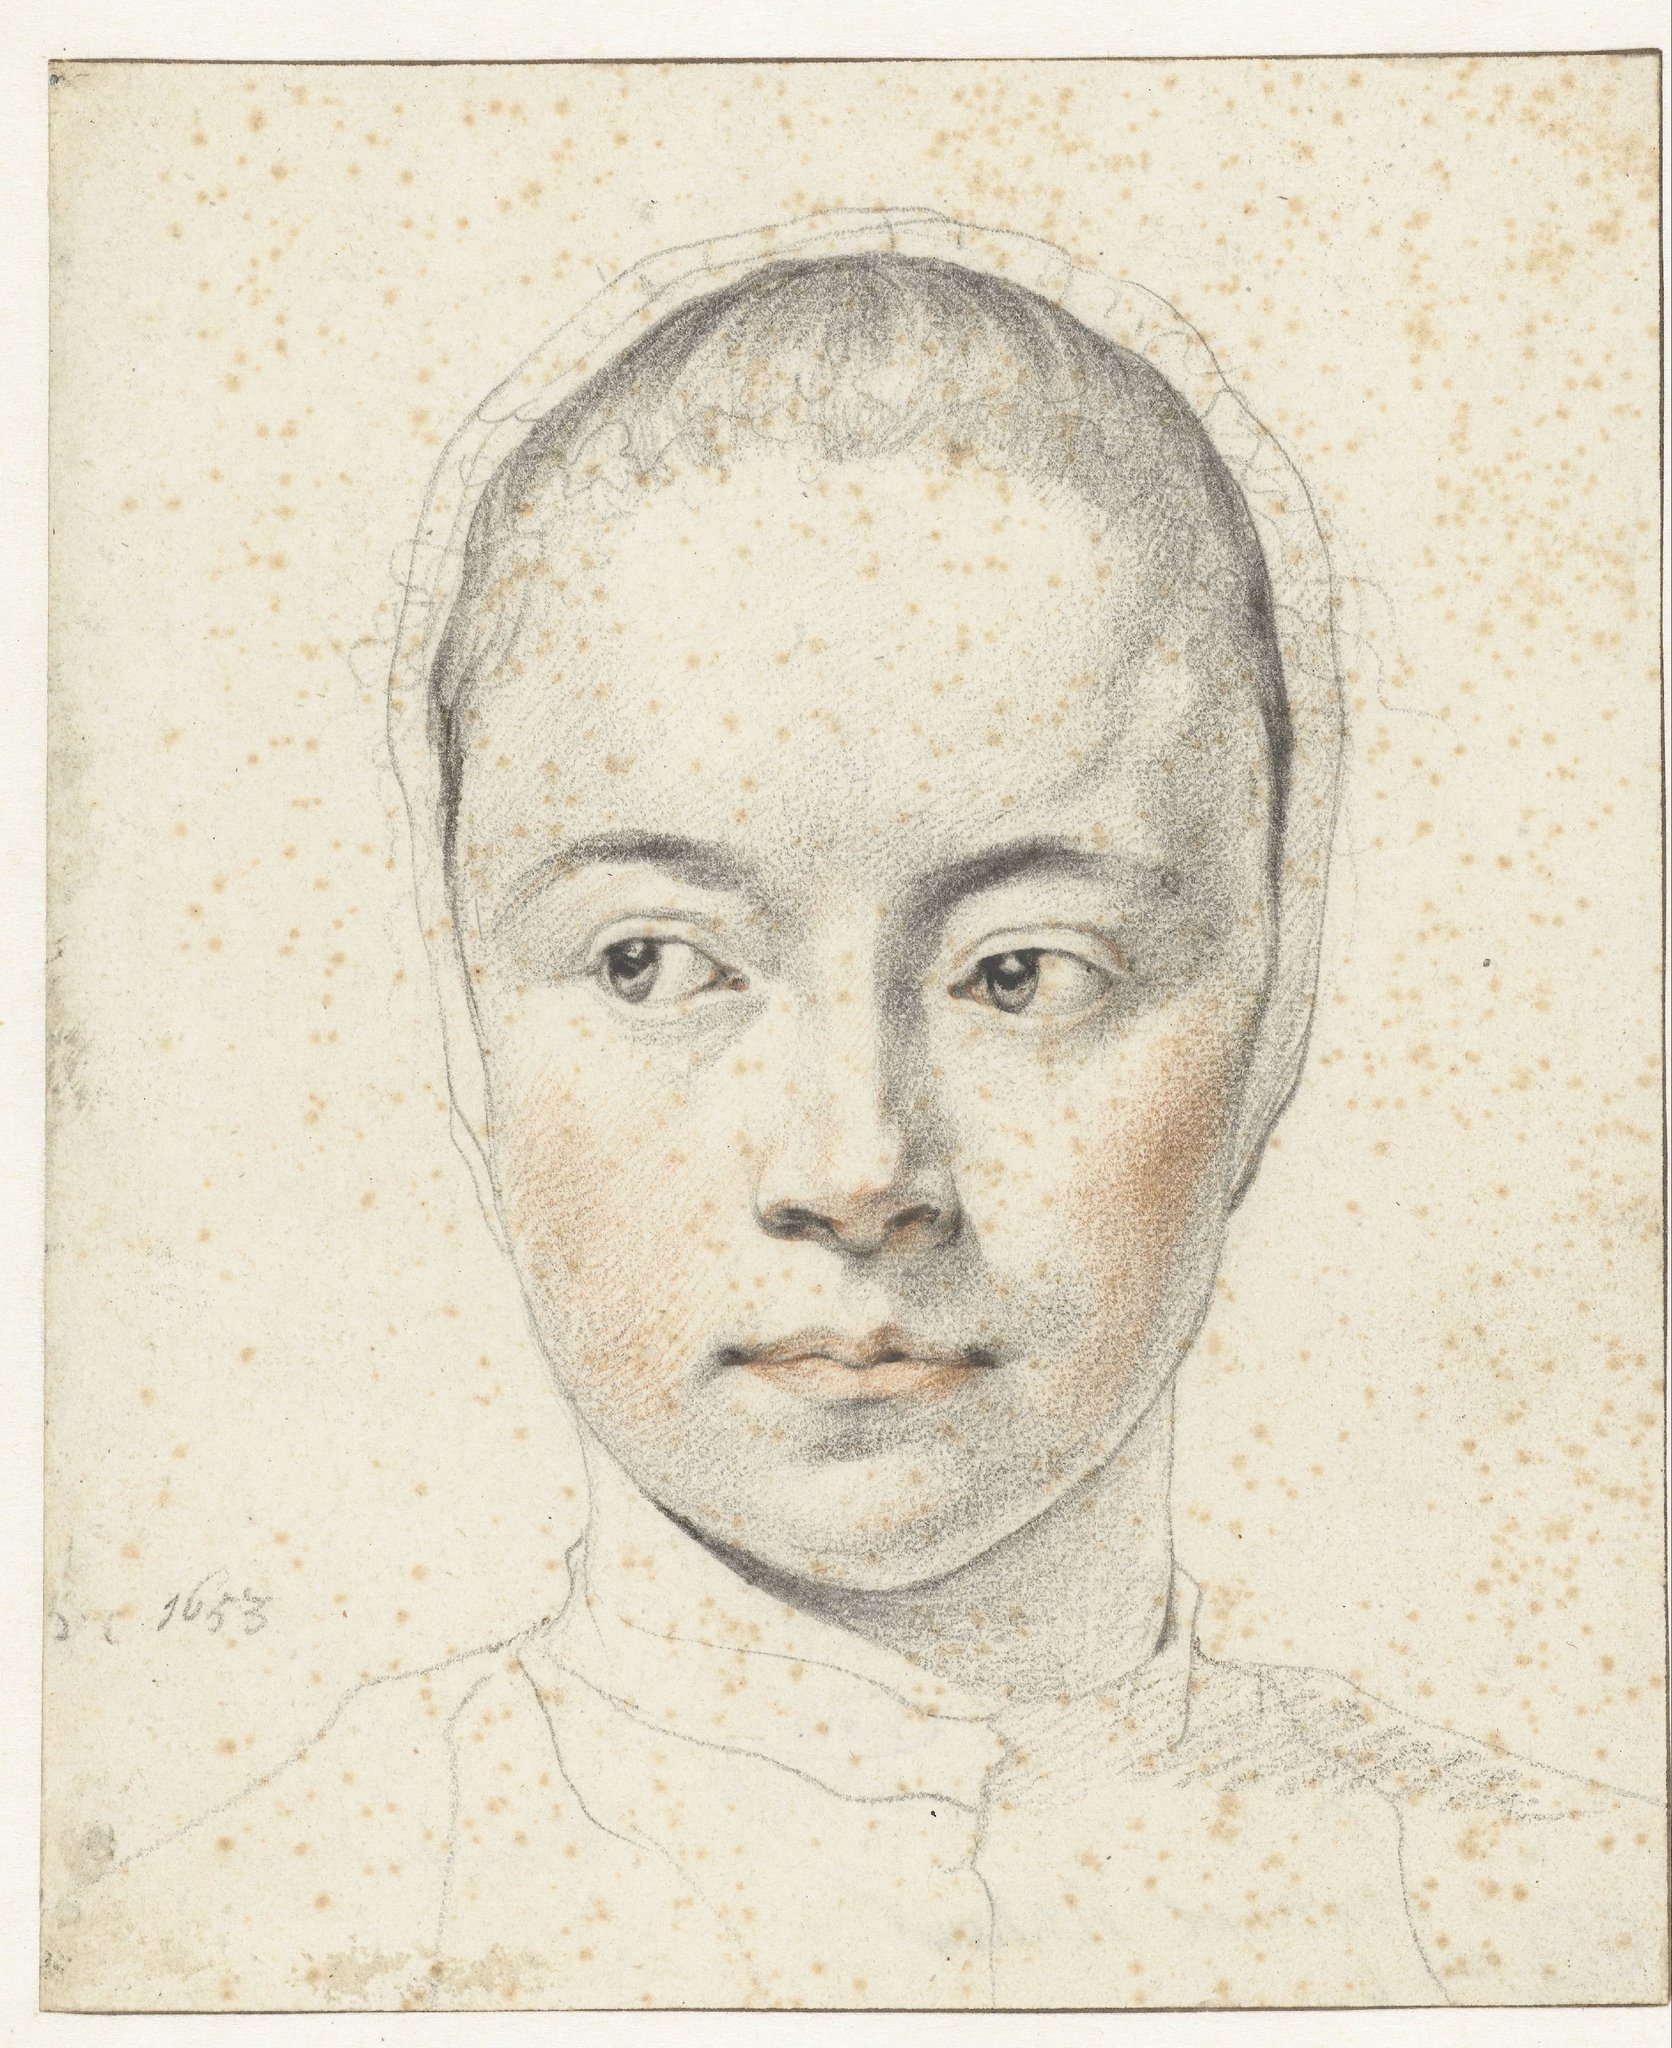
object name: drawing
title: Portret van een onbekend meisje met een mutsje op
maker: leendert van der cooghen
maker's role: draughtsman, print maker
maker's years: 1632-1681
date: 1653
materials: chalk, paper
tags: anonymous historical person portrayed alone - bb - woman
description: Leendert van der Cooghen was vooral tekenaar van figuren en portretten, al zijn er ook enkele schilderijen van hem bekend. Hij was een vermogend man en hoefde niet van zijn werk te leven. Het gebruik van twee kleuren krijt heeft hij van zijn Vlaamse leermeester Jacob Jordaens overgenomen. Ook Hendrick Goltzius maakte in het begin van de eeuw in Haarlem portretten in rood en zwrat krijt.